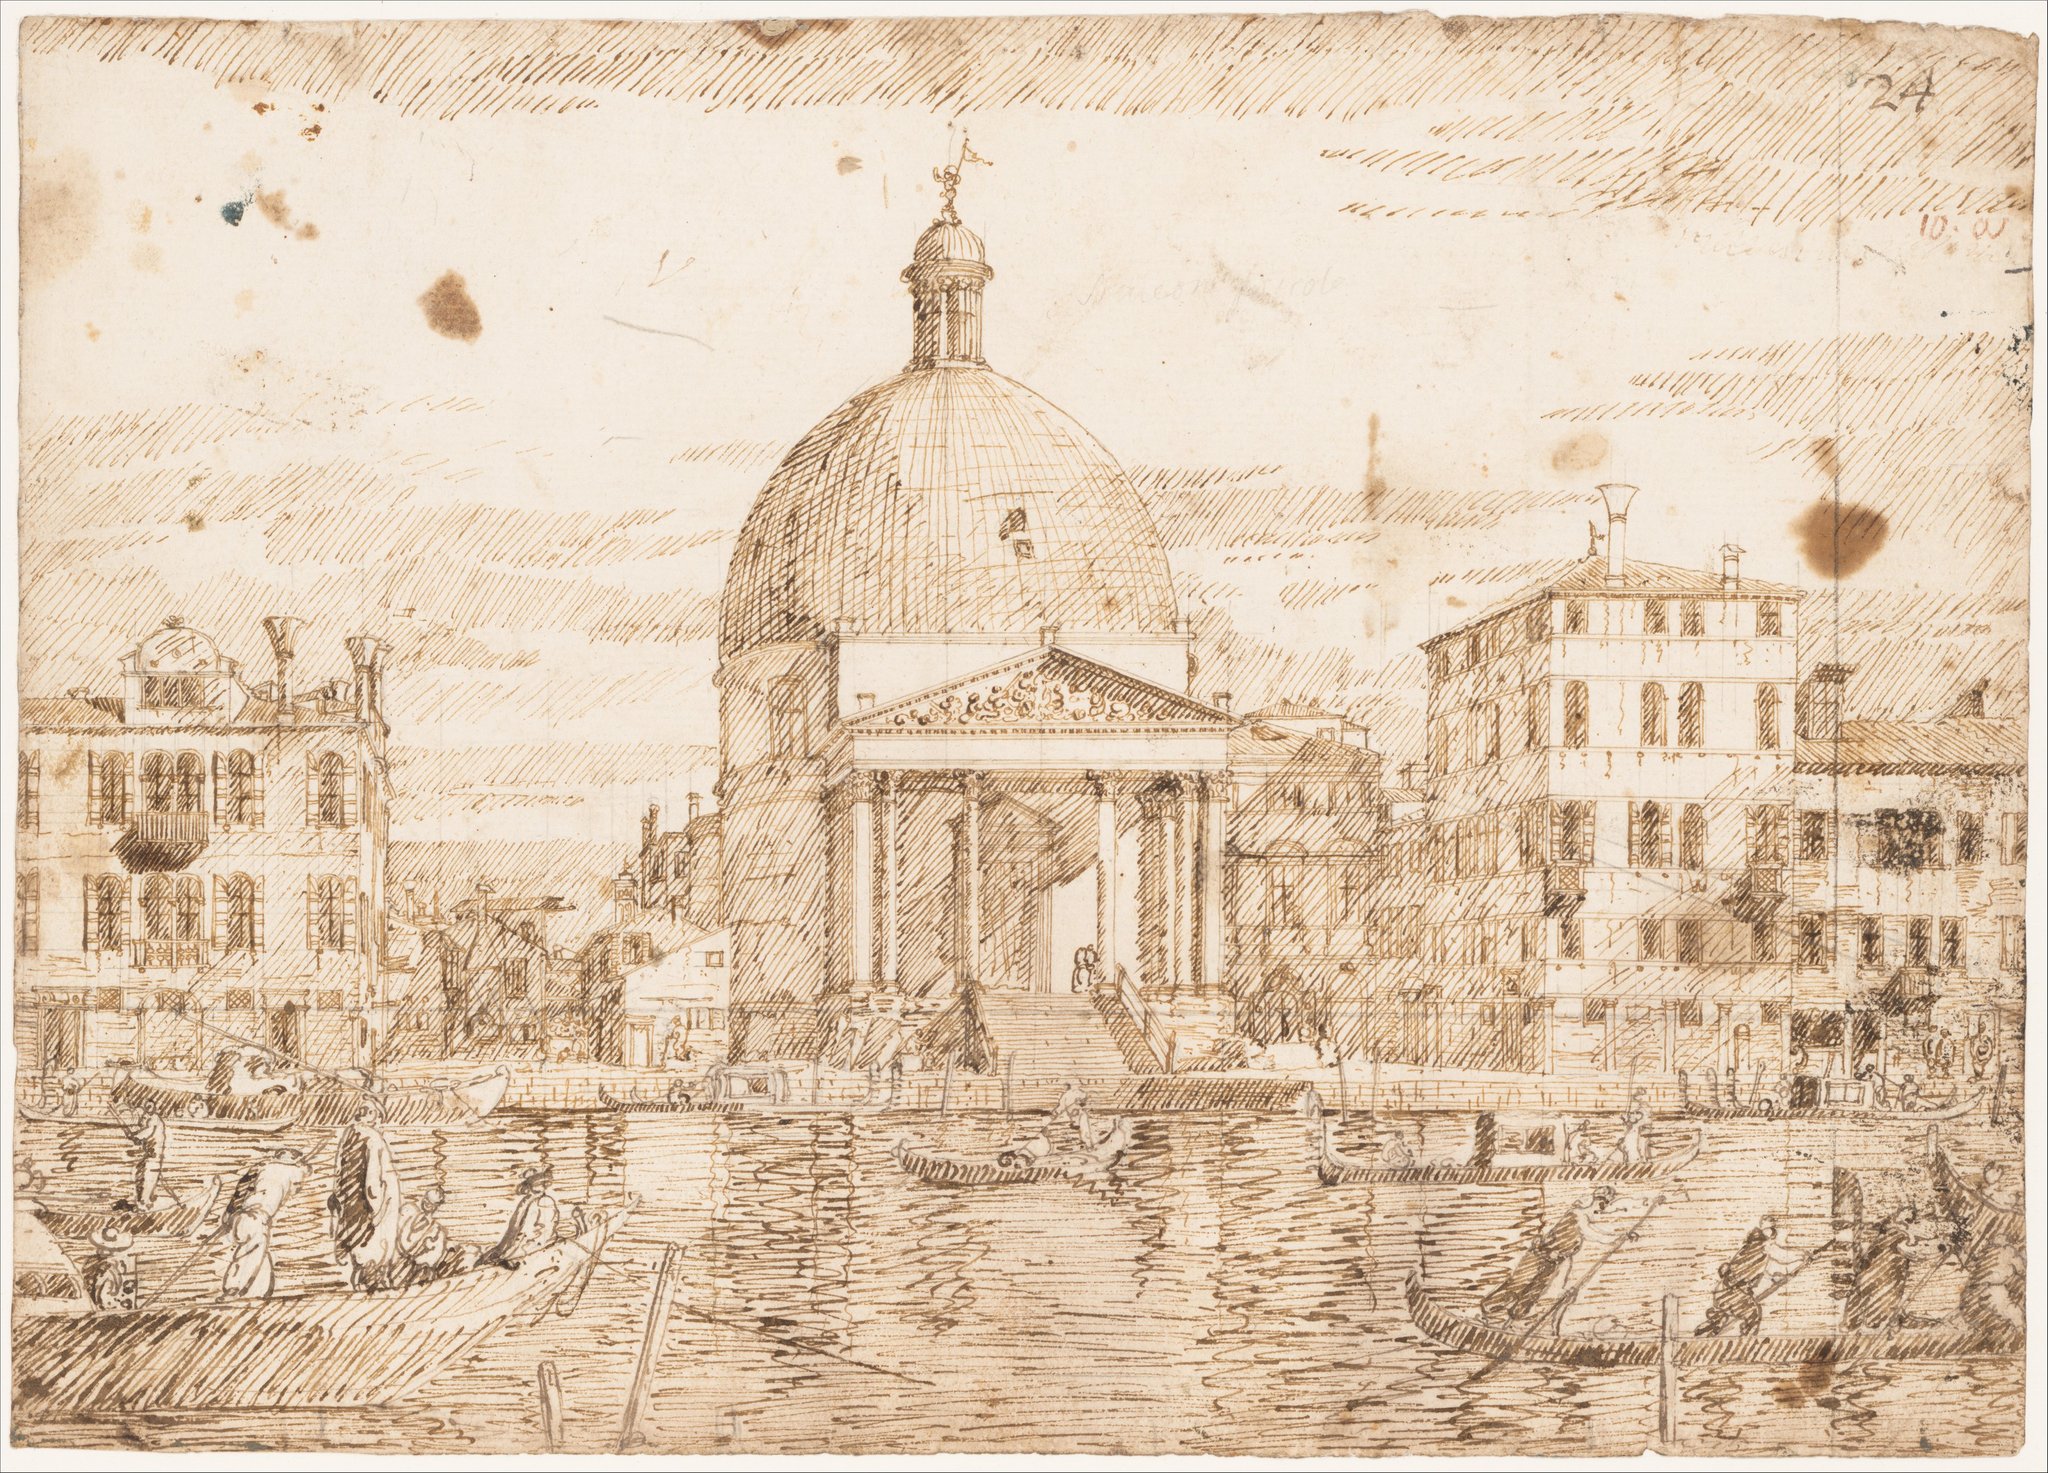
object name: drawing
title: San Simeone Piccolo, Venice, Seen from the Grand Canal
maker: bernardo bellotto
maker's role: artist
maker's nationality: italian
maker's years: 1722-1780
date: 1721-1780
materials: chalk, graphite, ink, lead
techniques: drawing, pen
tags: buildings,canals,boats,venice